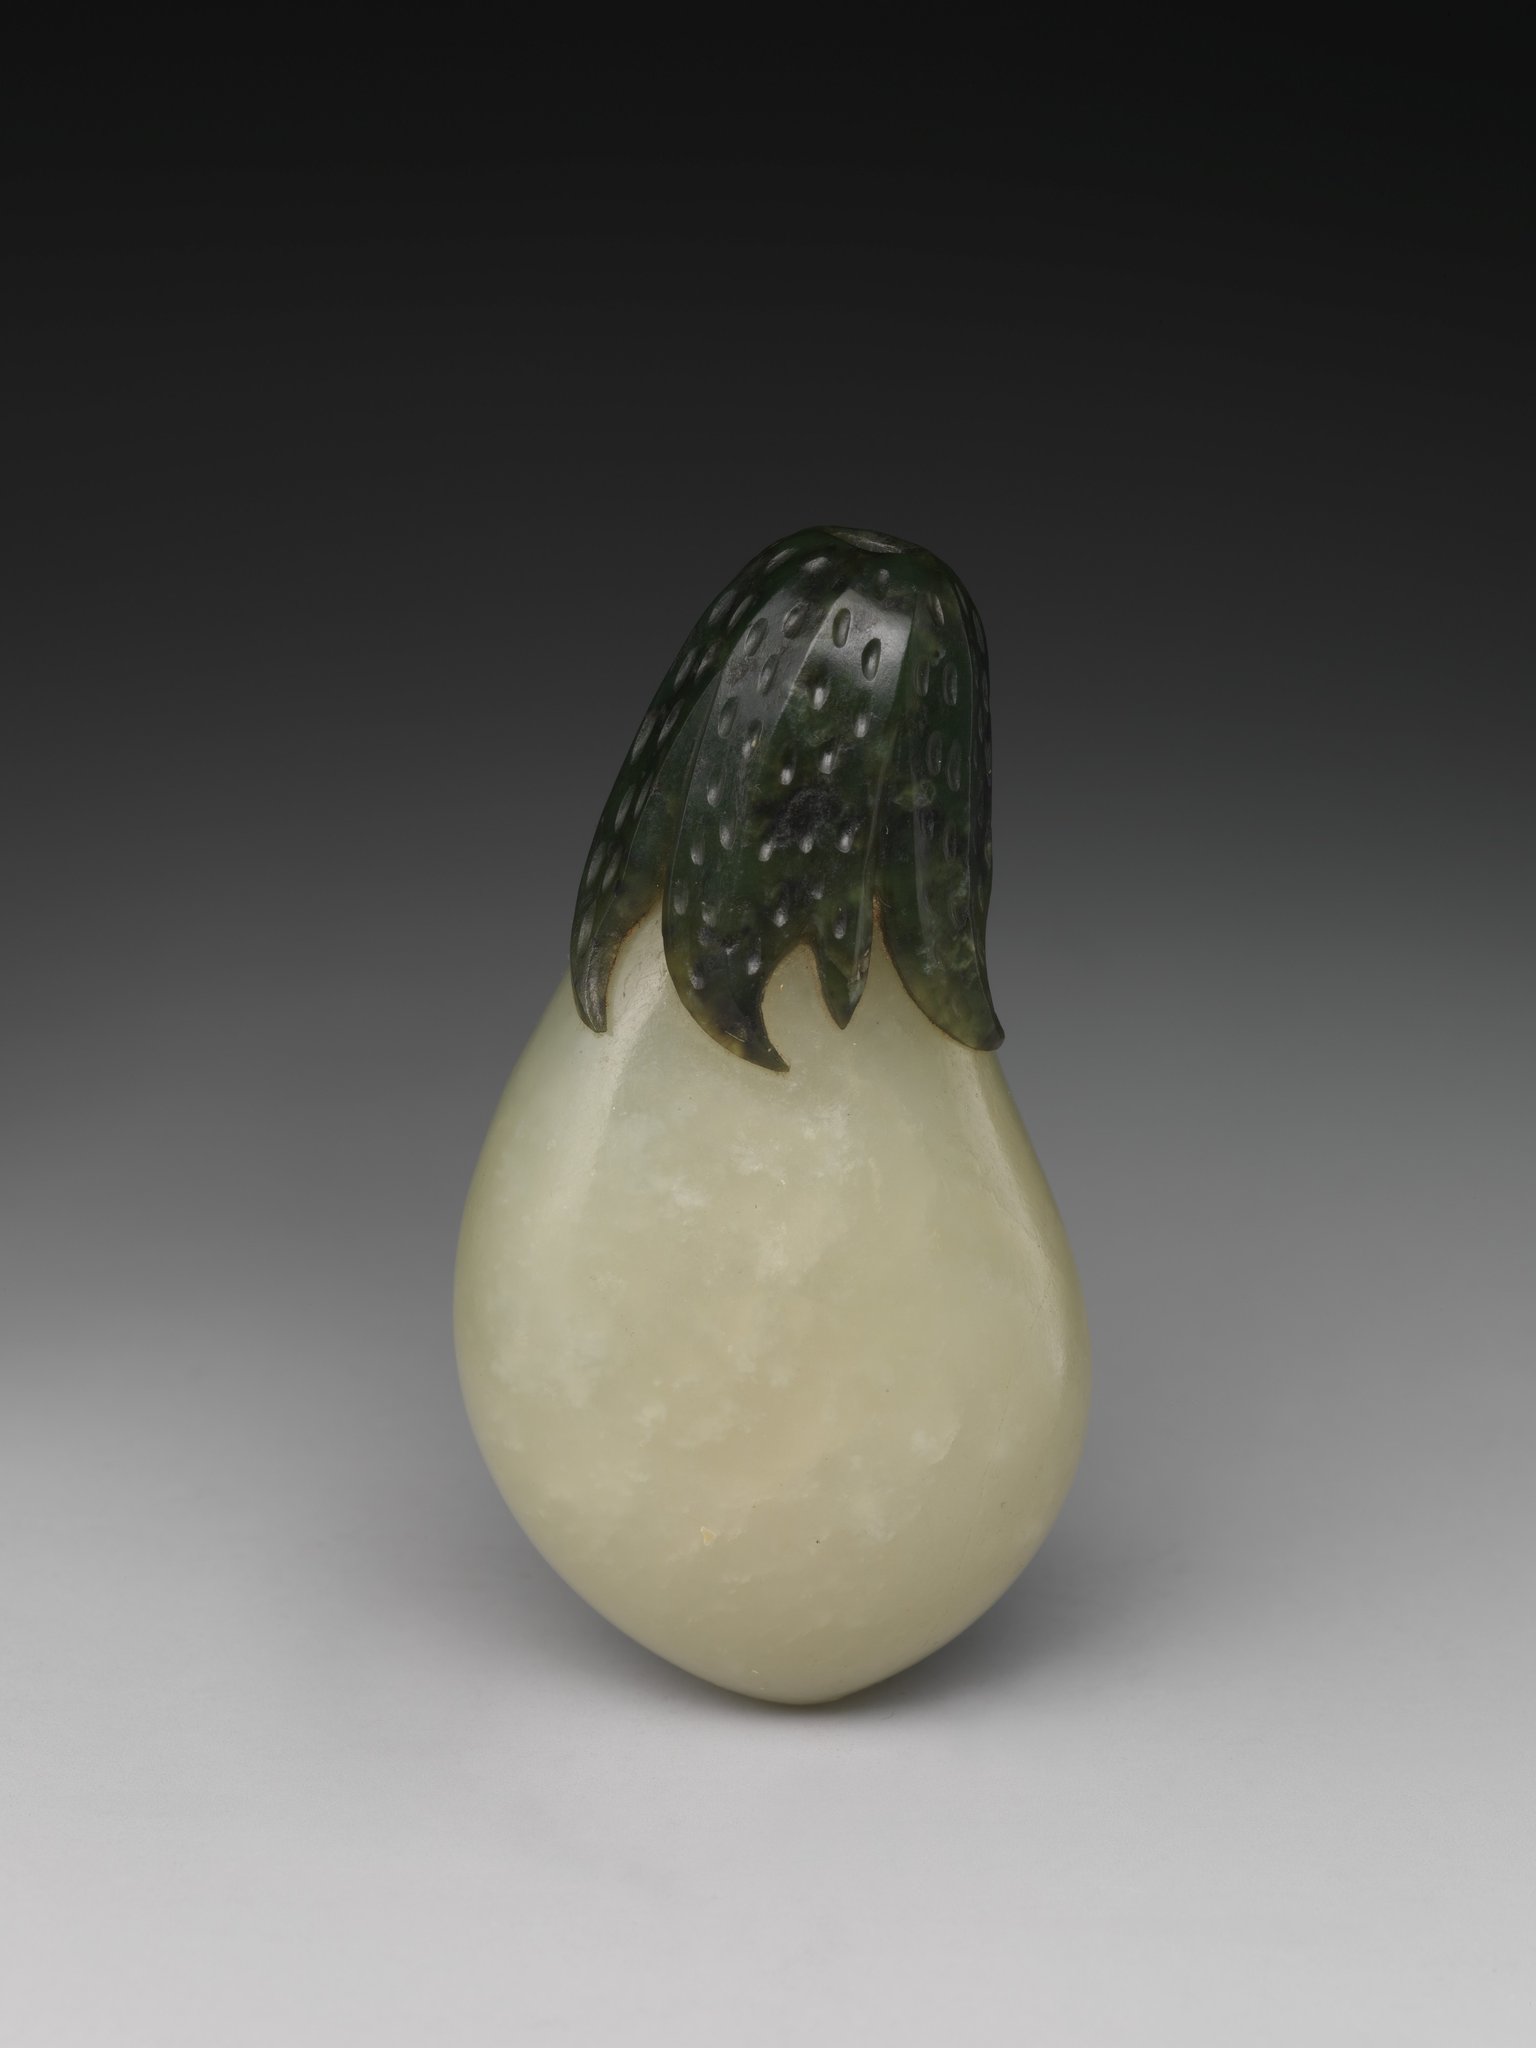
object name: snuff bottle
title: Snuff Bottle in the Shape of an Eggplant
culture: chinese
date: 1767-1800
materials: jade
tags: eggplants